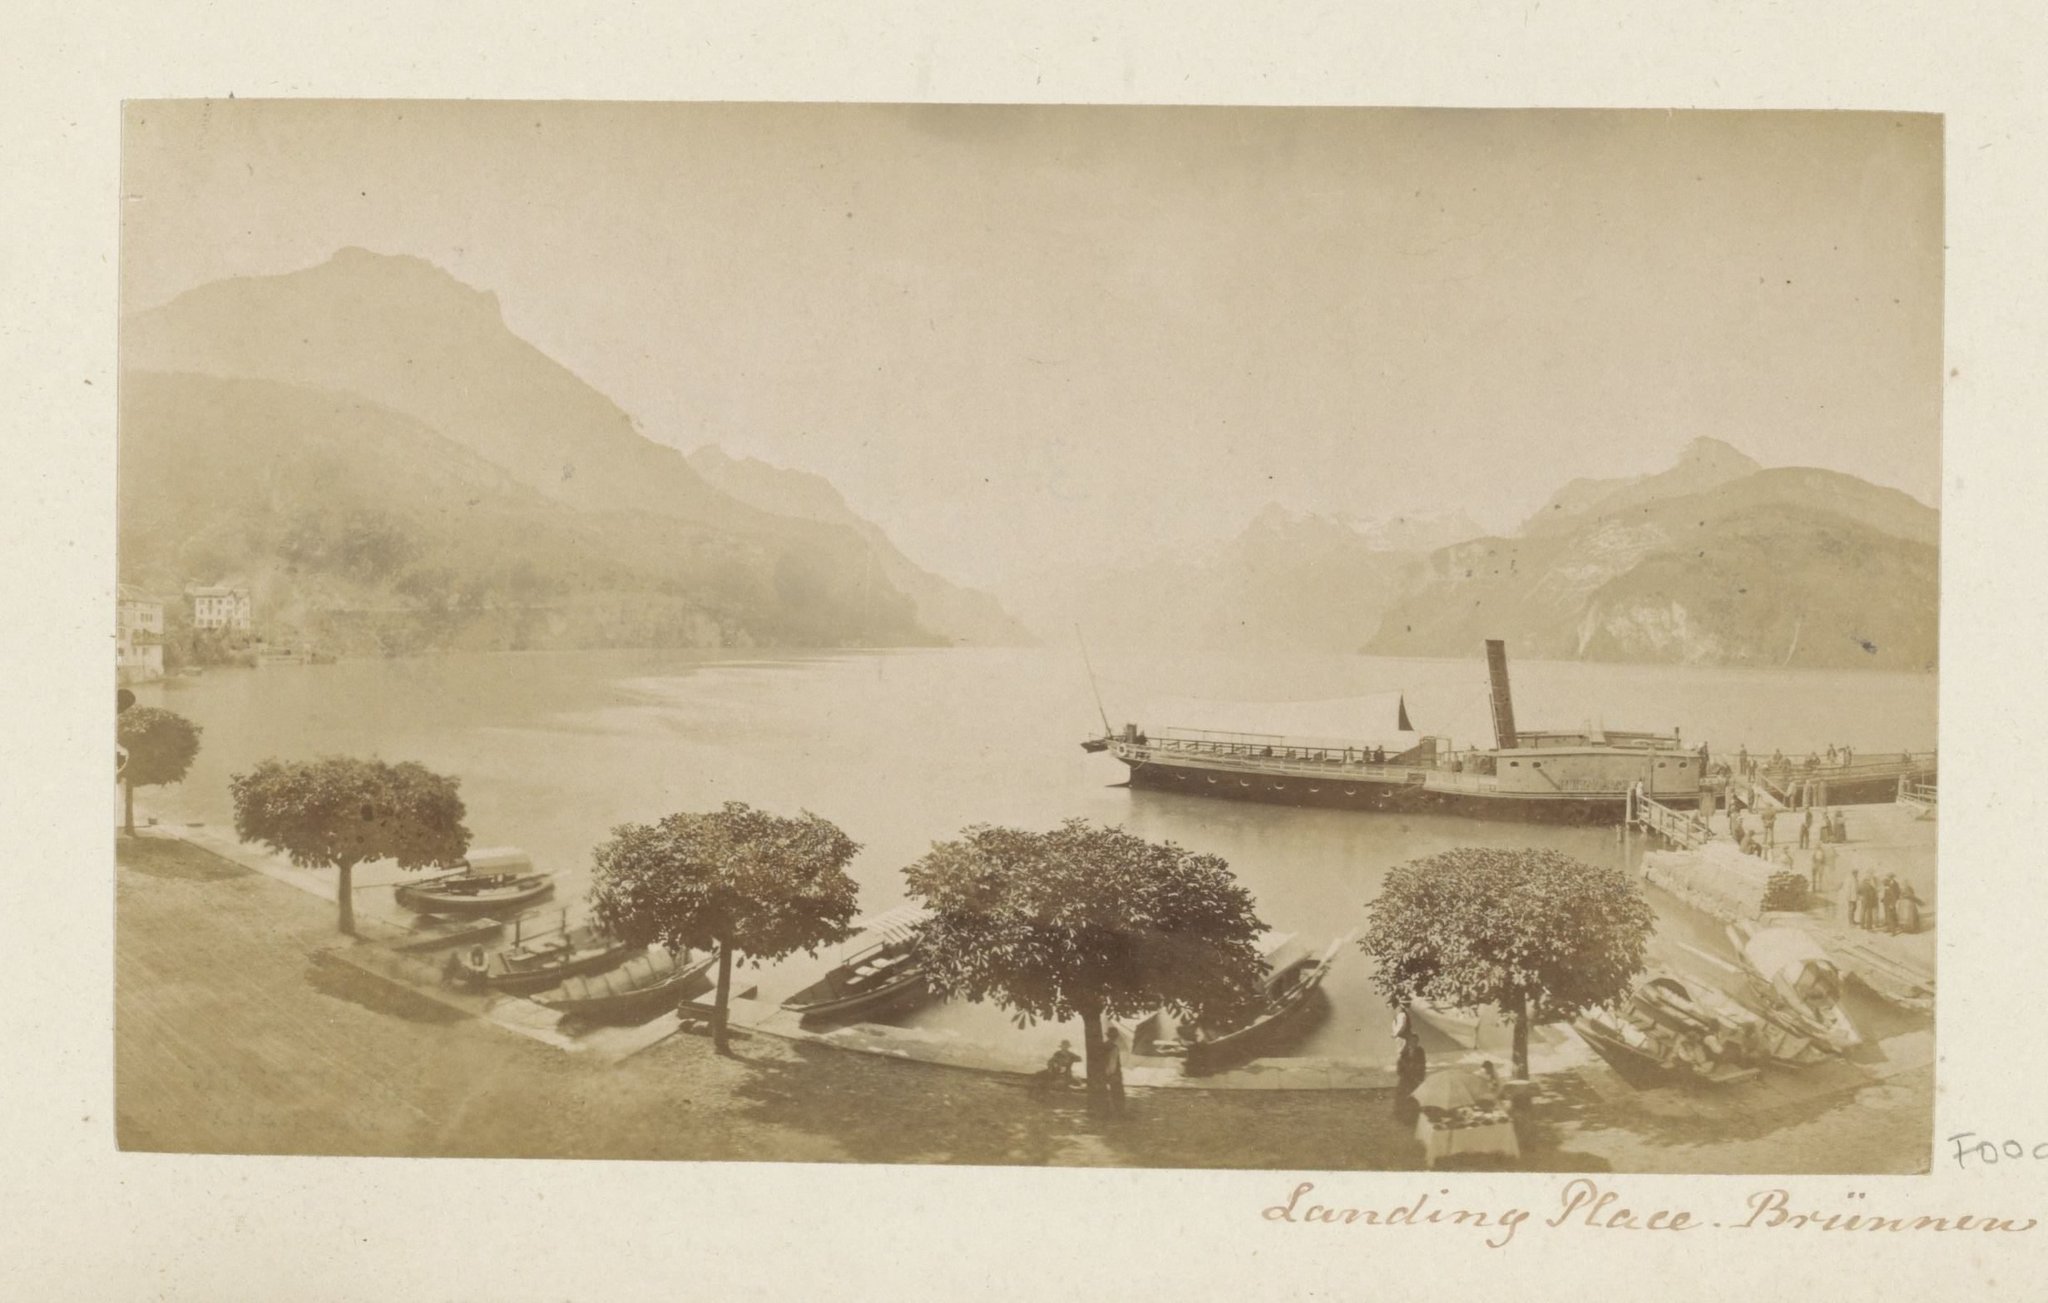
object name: photograph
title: Landing Place. Brünnen.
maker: Anonymous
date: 1860-1890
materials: paper, photographic support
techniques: albumen print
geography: brunnen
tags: harbour (+ view ~ vehicle, ship, etc.), lake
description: Onderdeel van Reisalbum met foto's van Zwitserland, Oostenrijk, Italië en Duitsland.